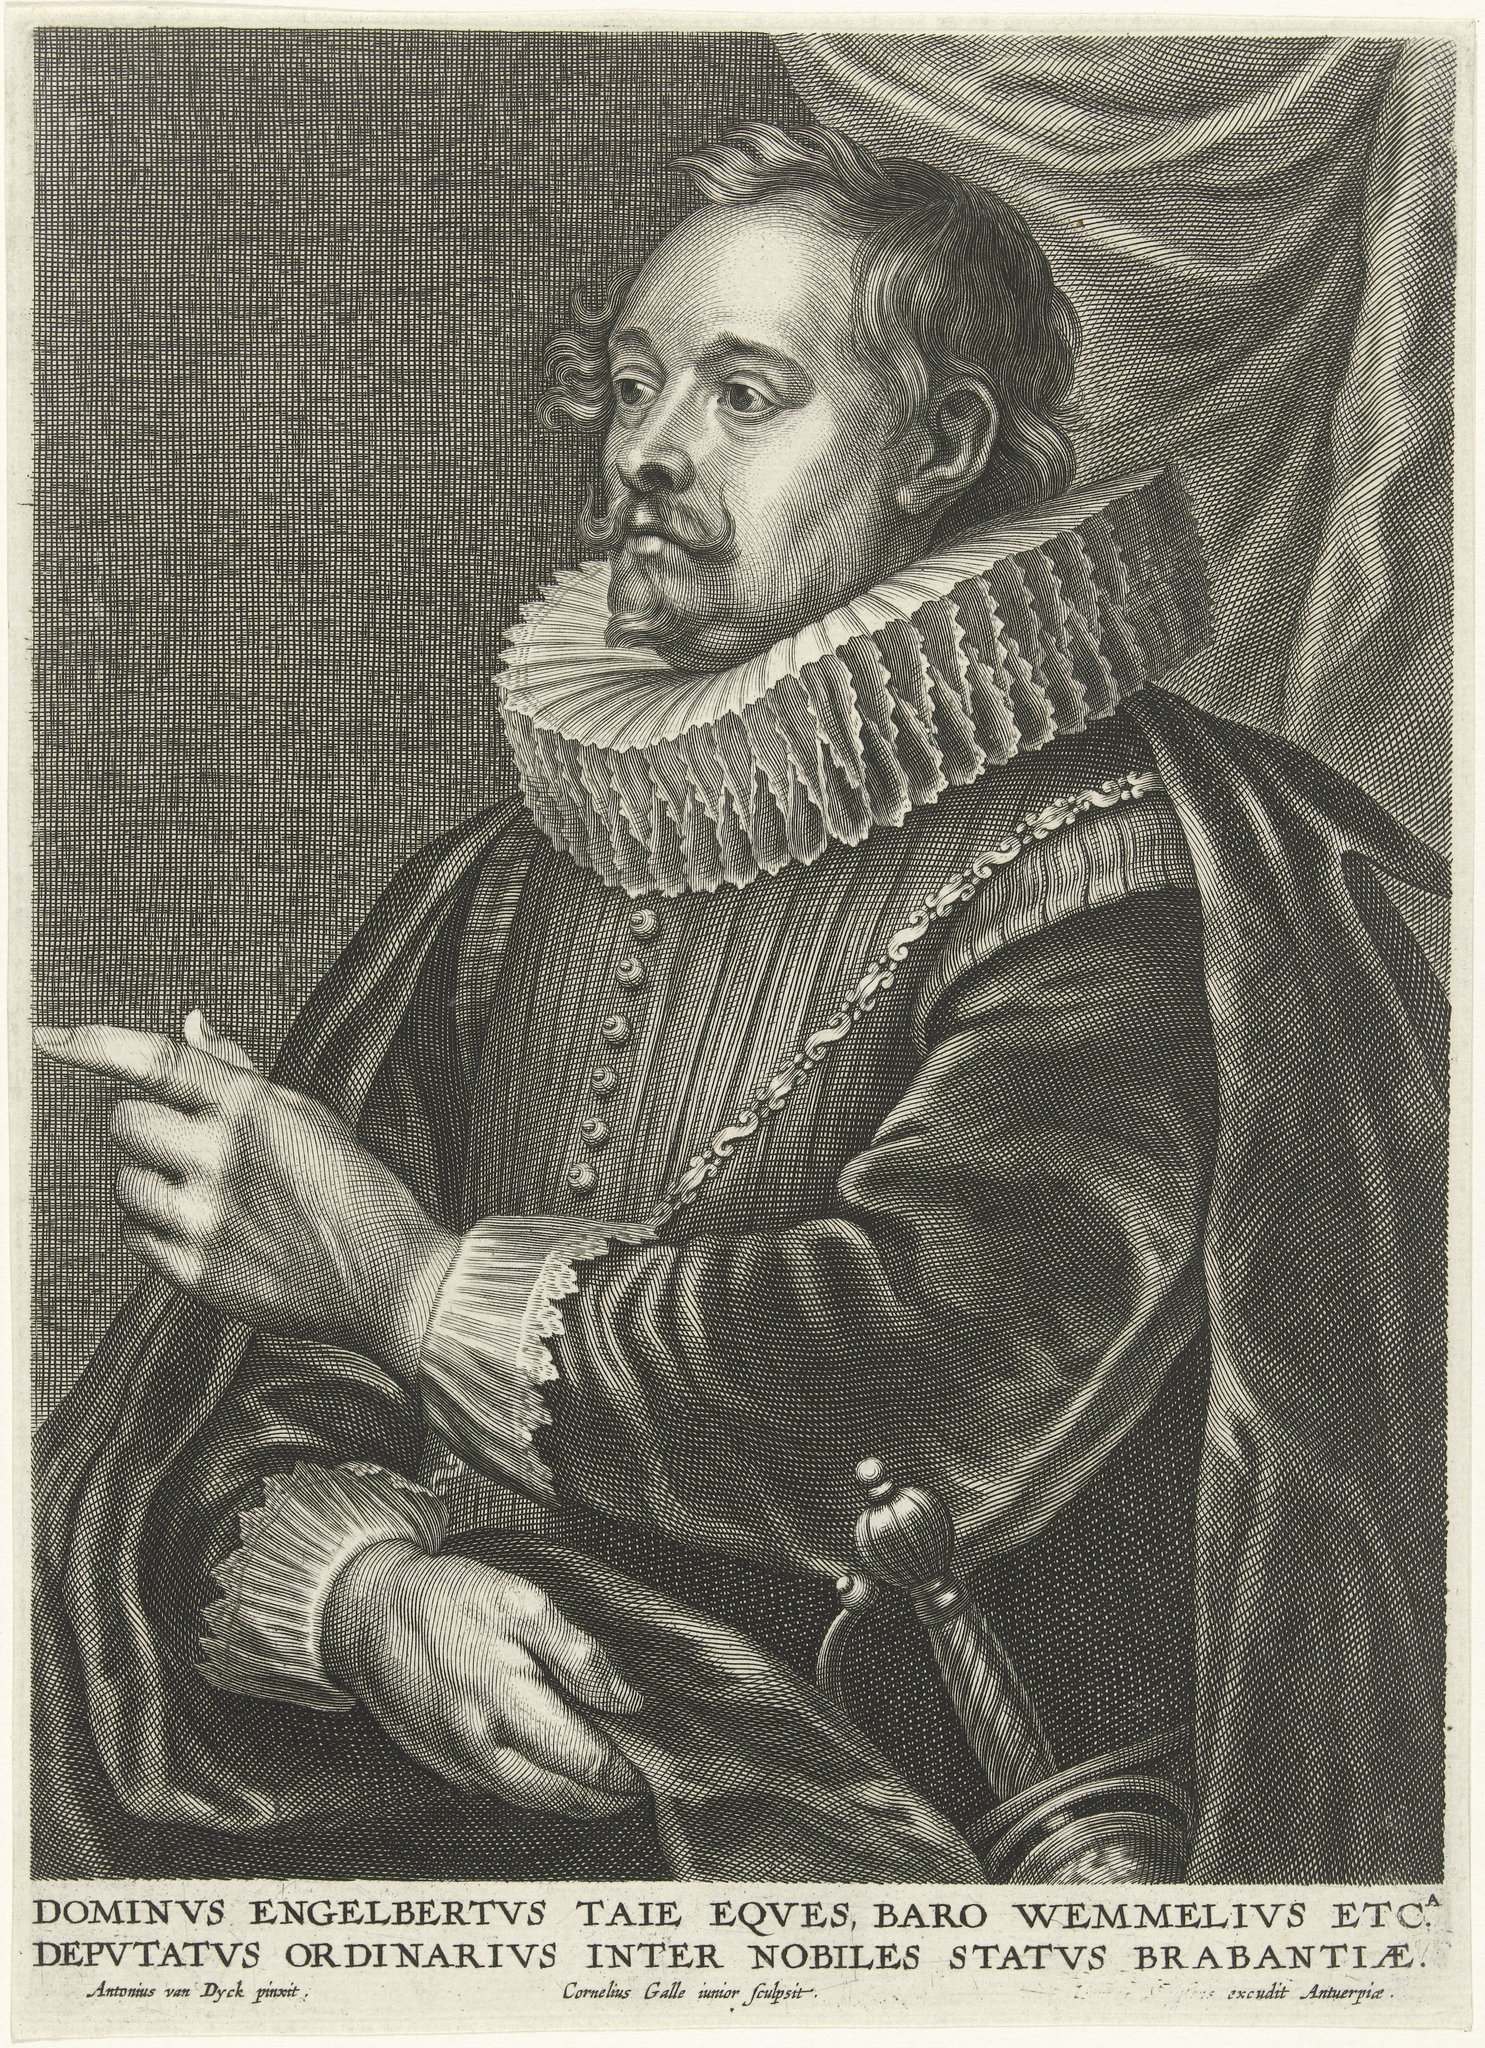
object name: print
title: Portret van Engelbert Tajé, baron van Wemmel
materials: paper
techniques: engraving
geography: antwerp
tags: mayor, engelbert taye (baron van wemmel)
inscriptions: collector's mark: Lugt 2228